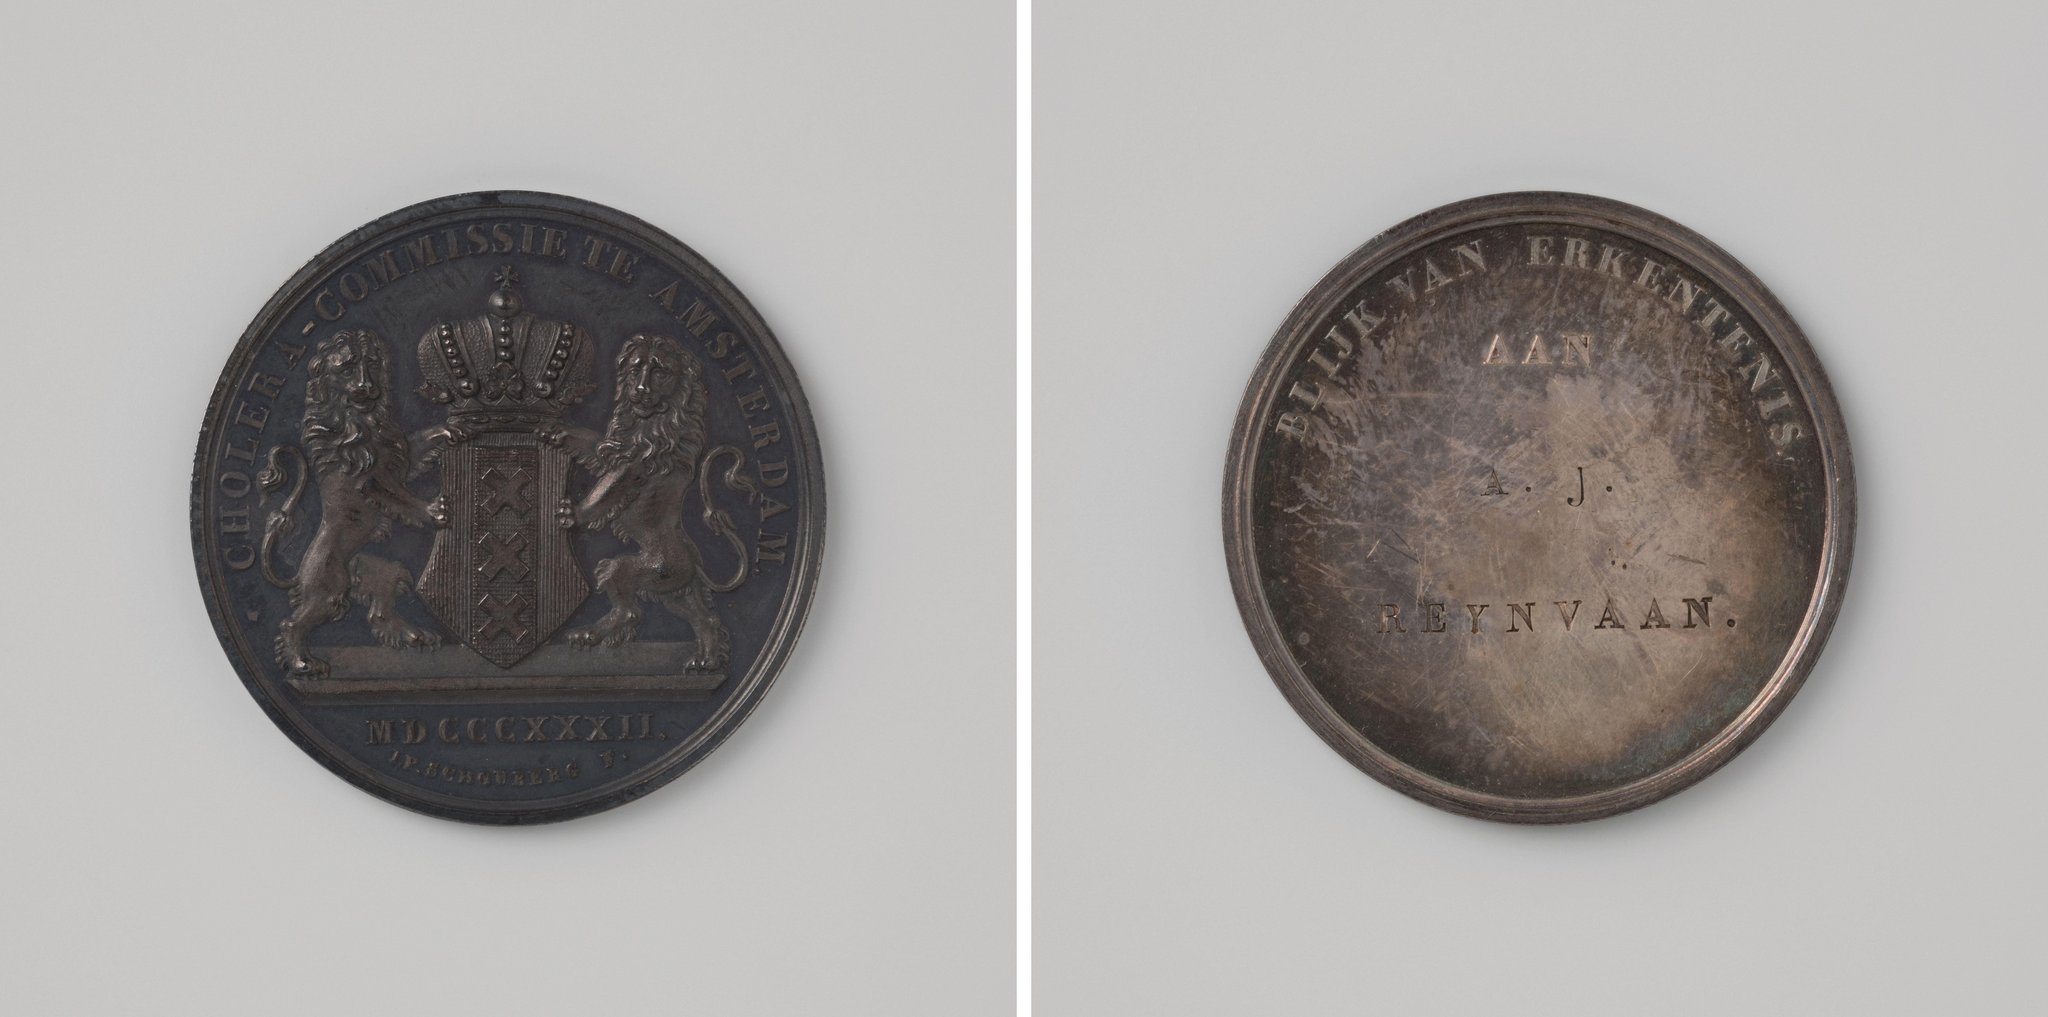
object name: history medal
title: Erepenning voor de wijkmeesters te Amsterdam bij de choleraepidemie 1832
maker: johannis petrus schouberg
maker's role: die cutter, draughtsman, print maker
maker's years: 1798-1864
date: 1832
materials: silver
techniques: printing, striking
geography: utrecht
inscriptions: inscription: ‘A.J. / REYNVAAN.’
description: Zilveren penning, op de voorzijde het gekroonde wapenschild van Amsterdam met dragers, met omschrift en afsnedetekst, op de keerzijde BLIJK VAN ERKENTENIS AAN waaronder inscriptieruimte.